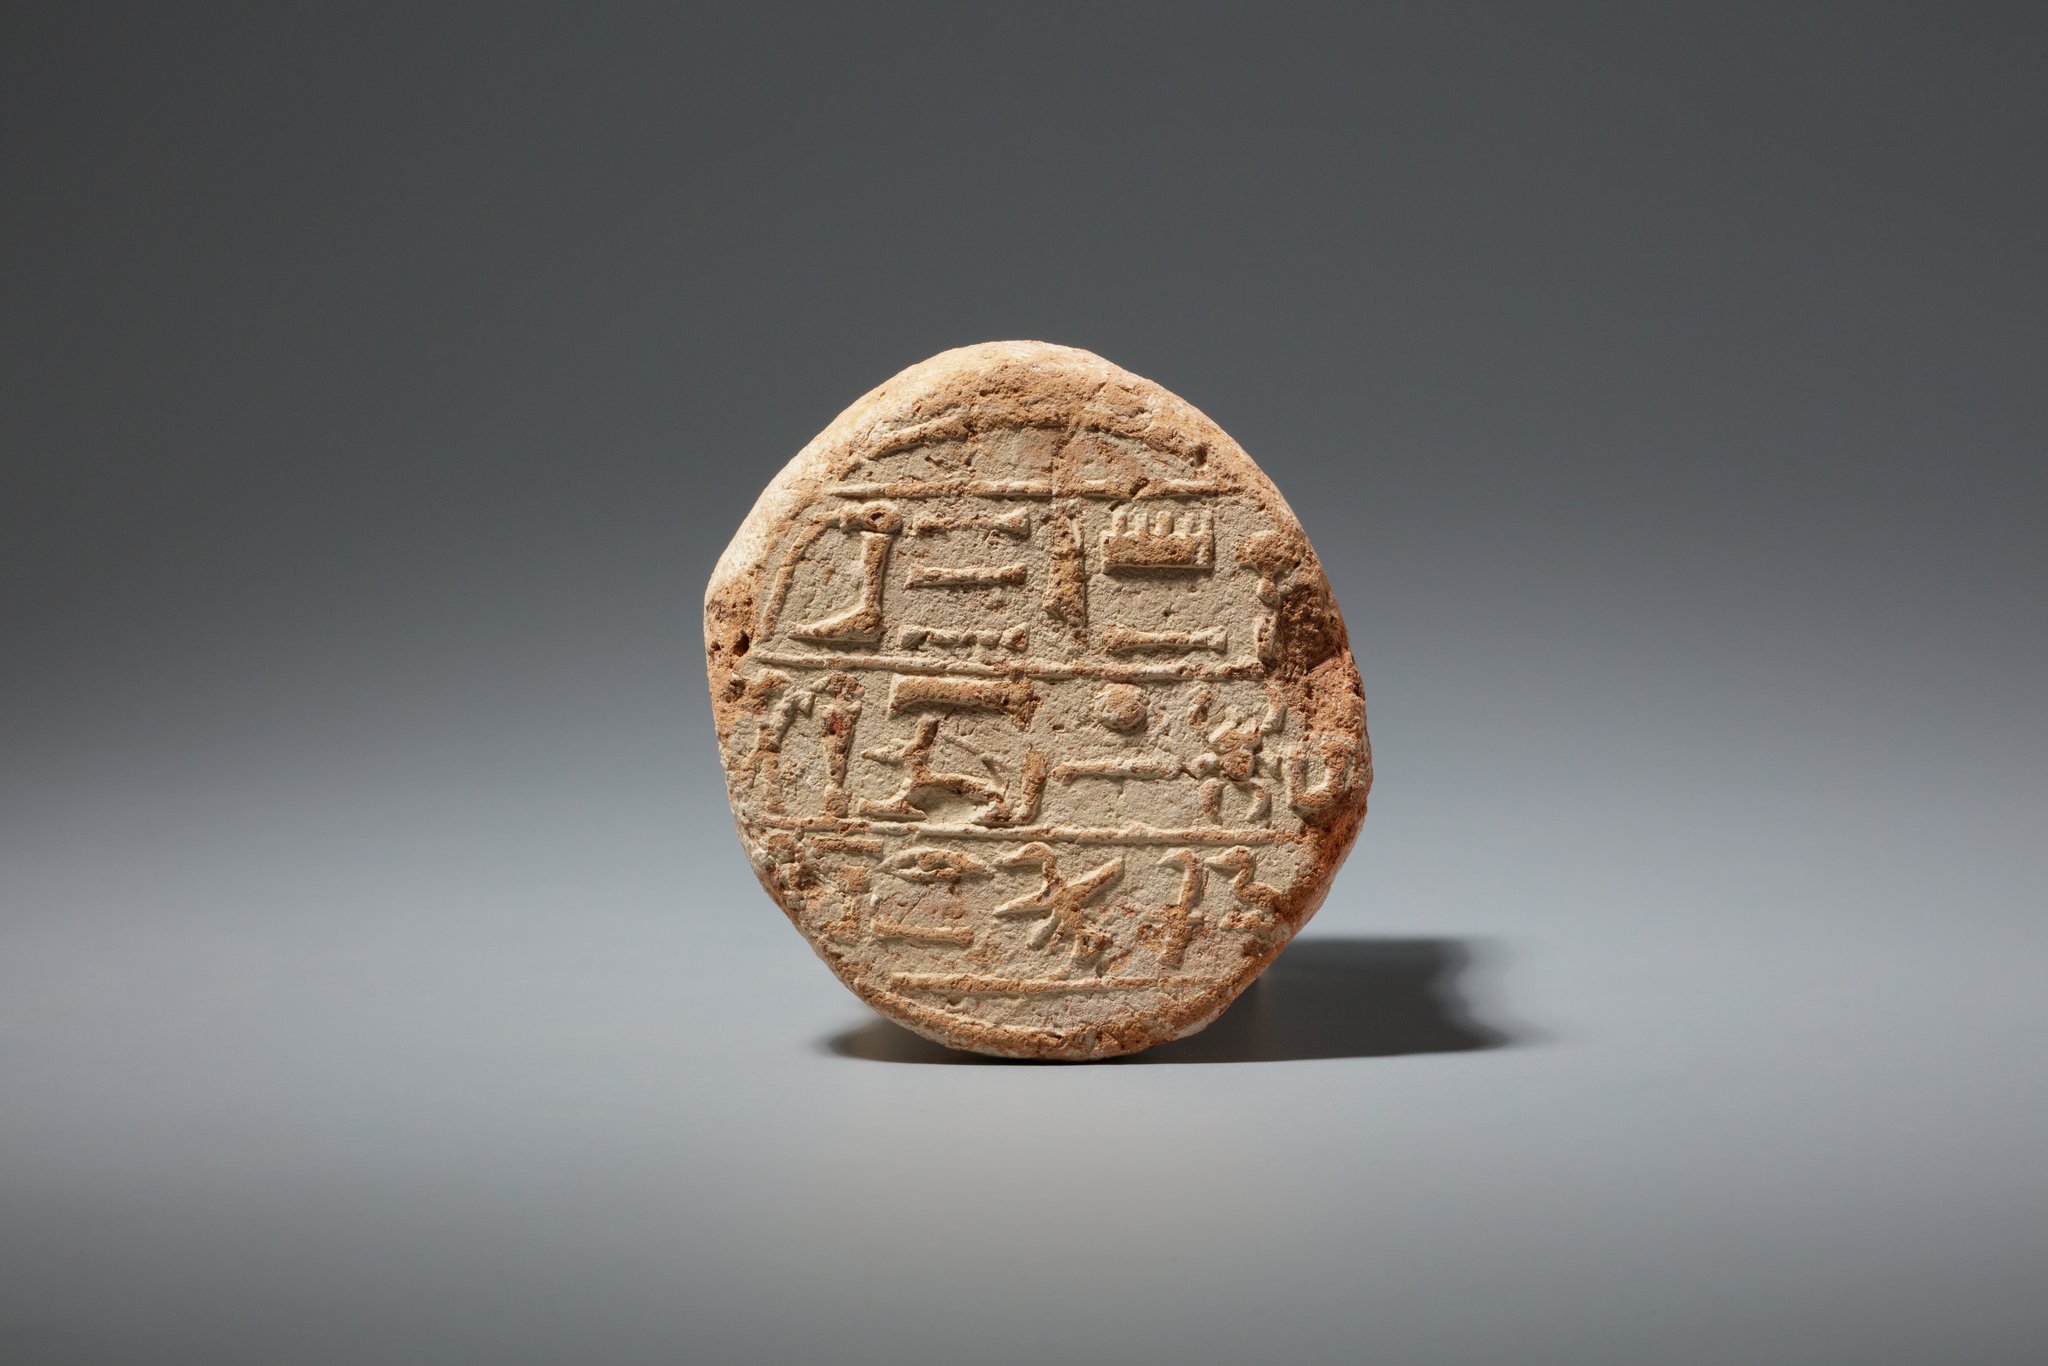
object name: cone, davy 523, aakheperkareseneb, wab, amun, pasanesut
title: Funerary Cone the Wab-Priest Aakheperkareseneb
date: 1504-1425 BCE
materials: pottery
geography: egypt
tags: hieroglyphs